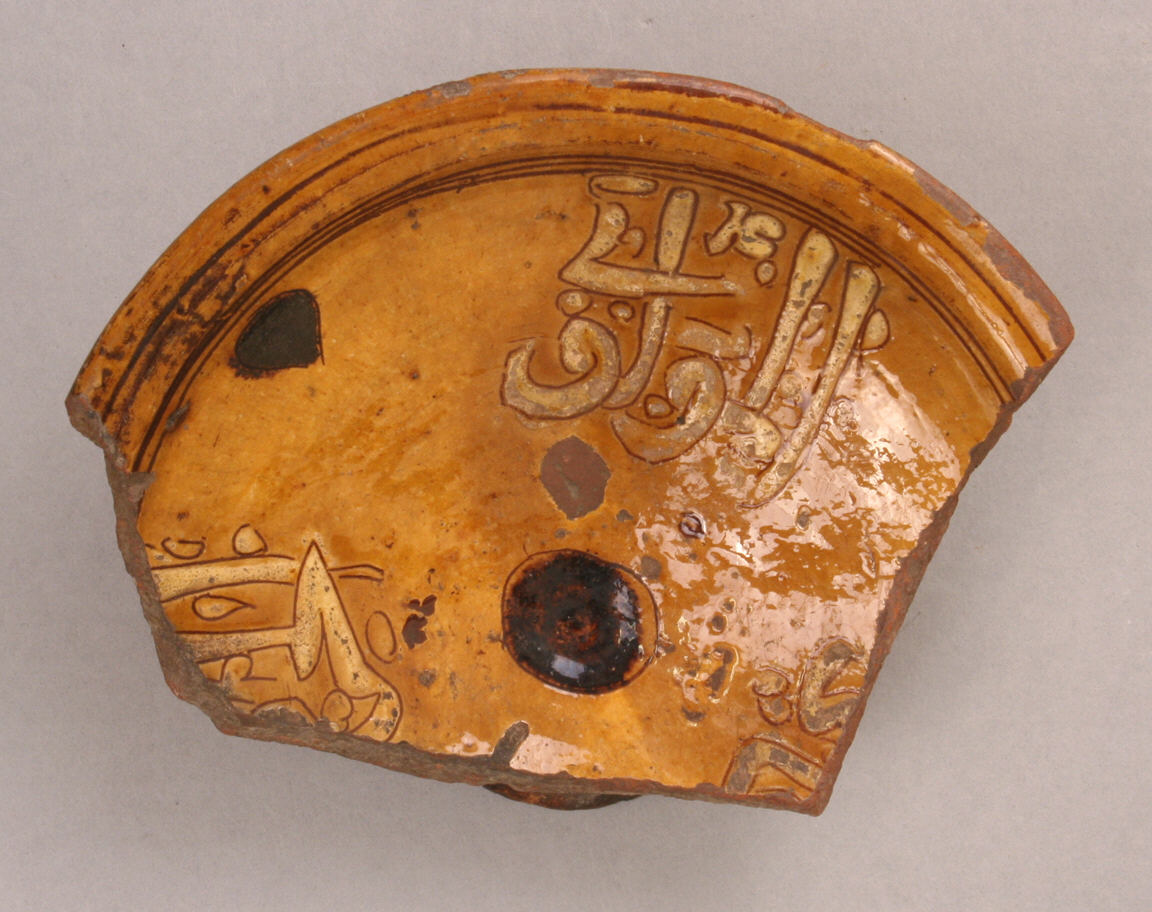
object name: ceramic fragment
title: Fragment of a Bowl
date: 1301-1500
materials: earthenware, glaze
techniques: coloring, incising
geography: egypt